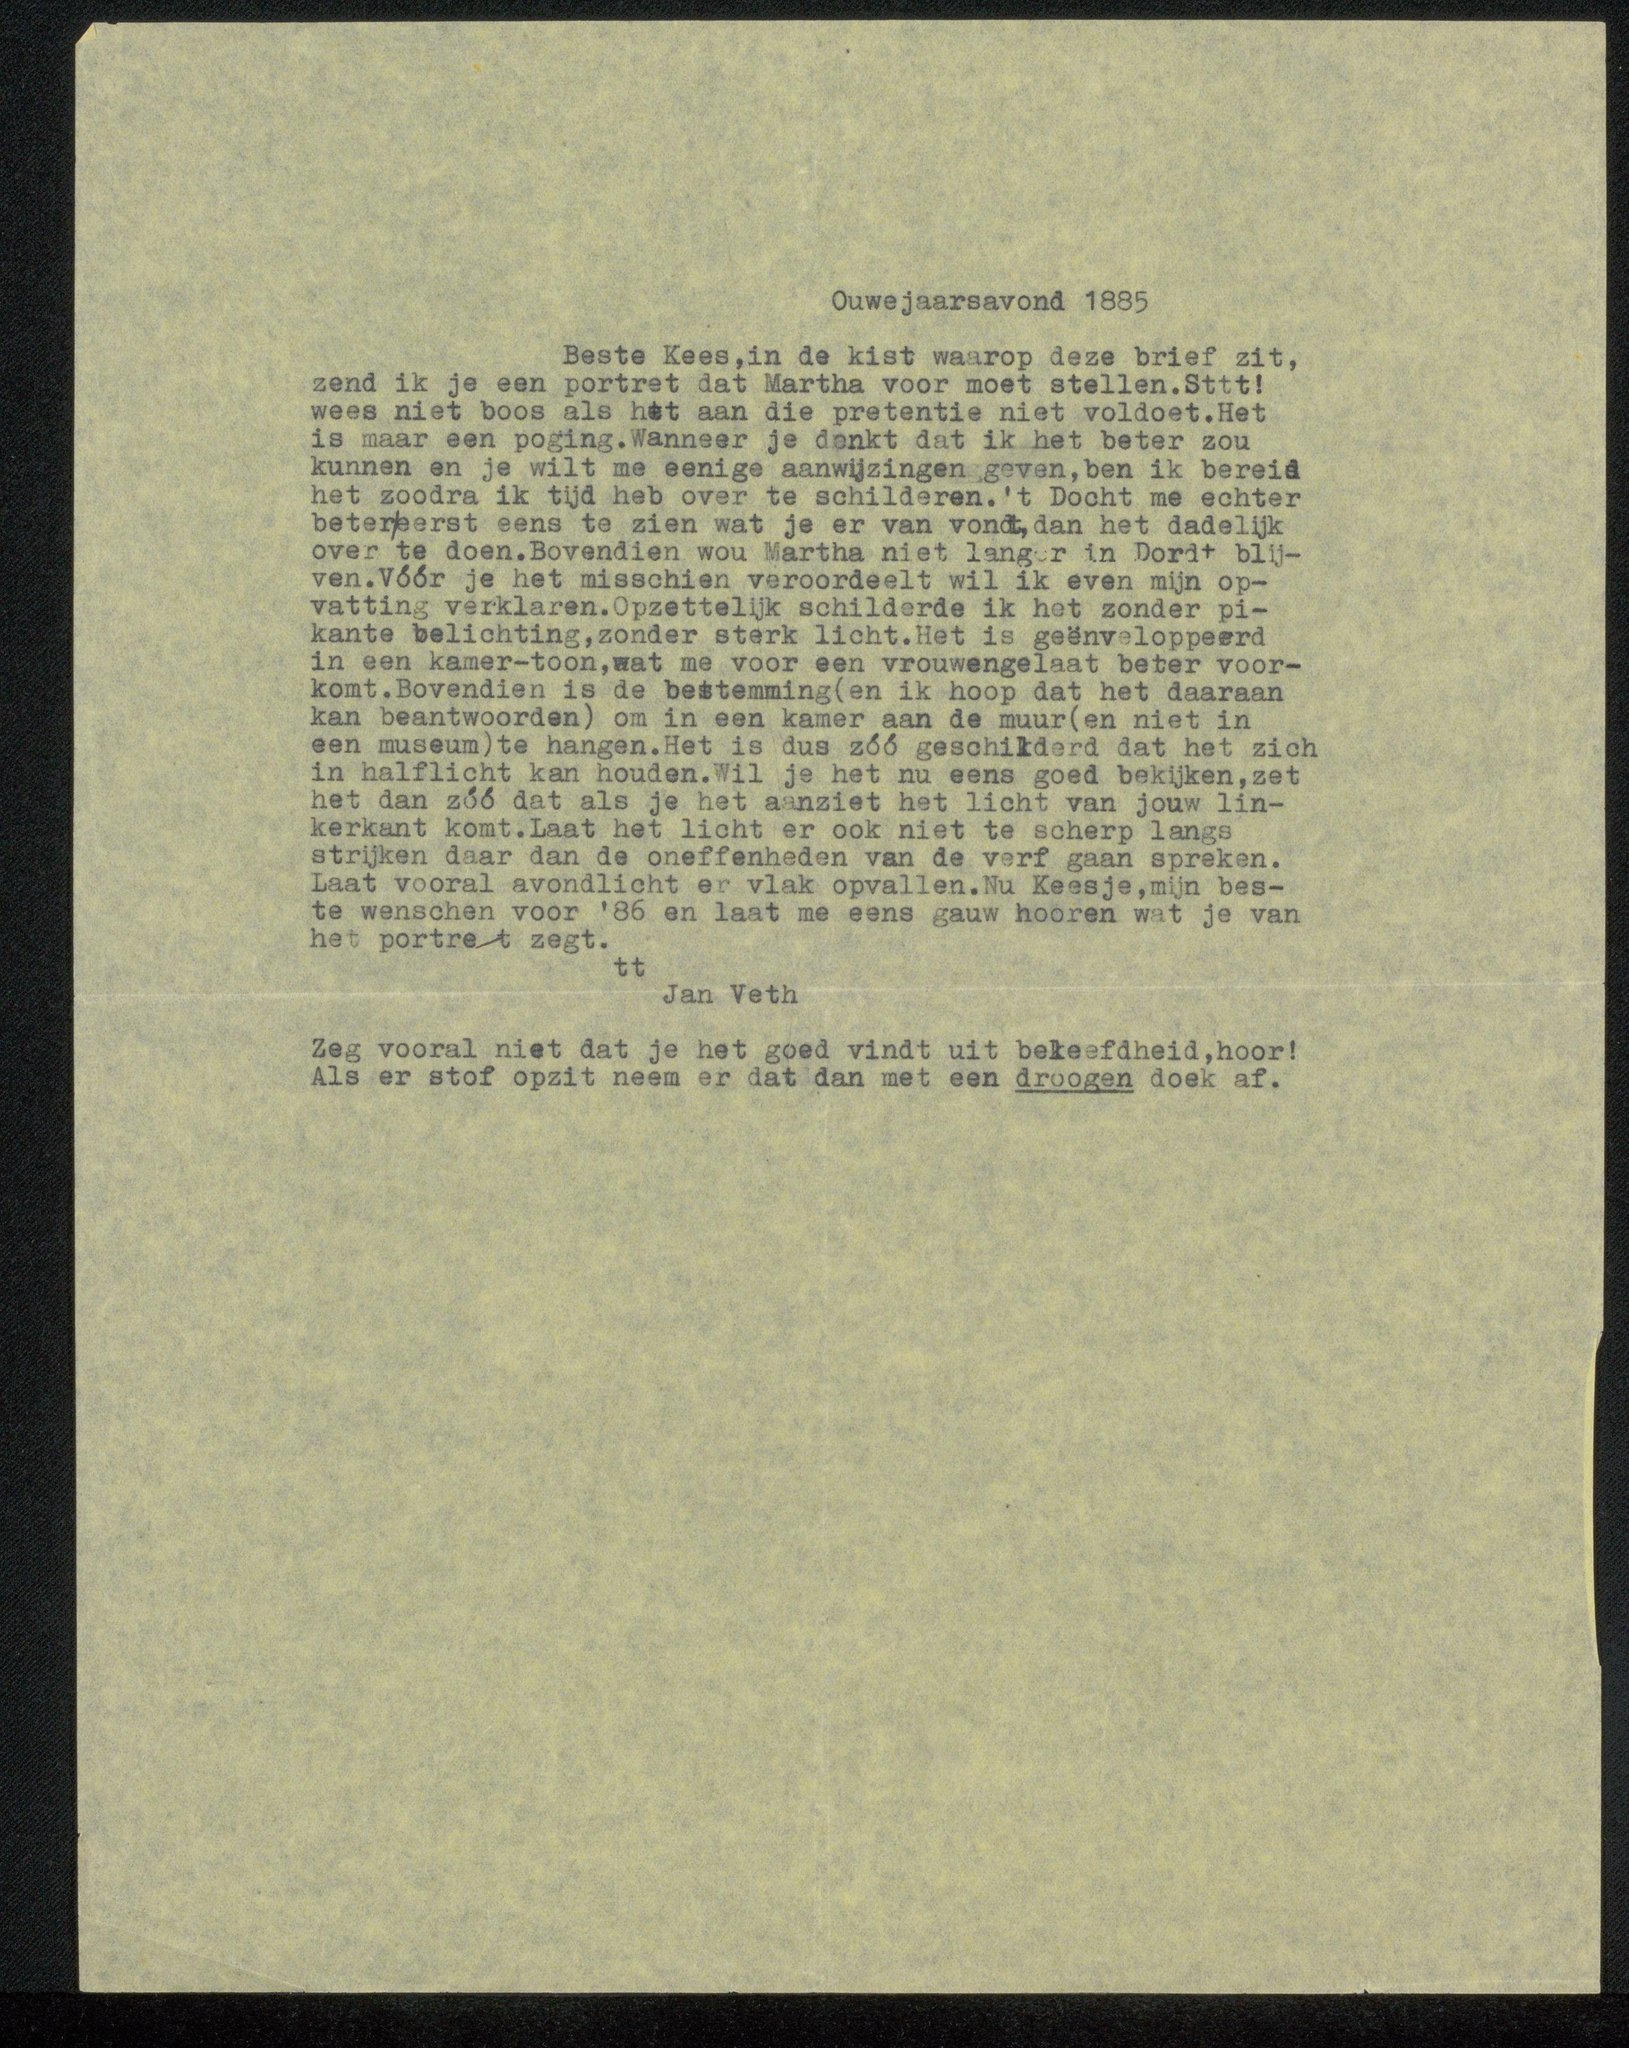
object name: letter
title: Afschrift van een brief aan Frederik van Eeden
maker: Anonymous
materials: ink, paper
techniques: typewriting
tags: haarlem, frederik van eeden, deventer, martha van vloten, painting (including book-illumination, miniature-painting), historical persons (portraits and scenes from the life), dordrecht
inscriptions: collector's mark: ‘RPK’